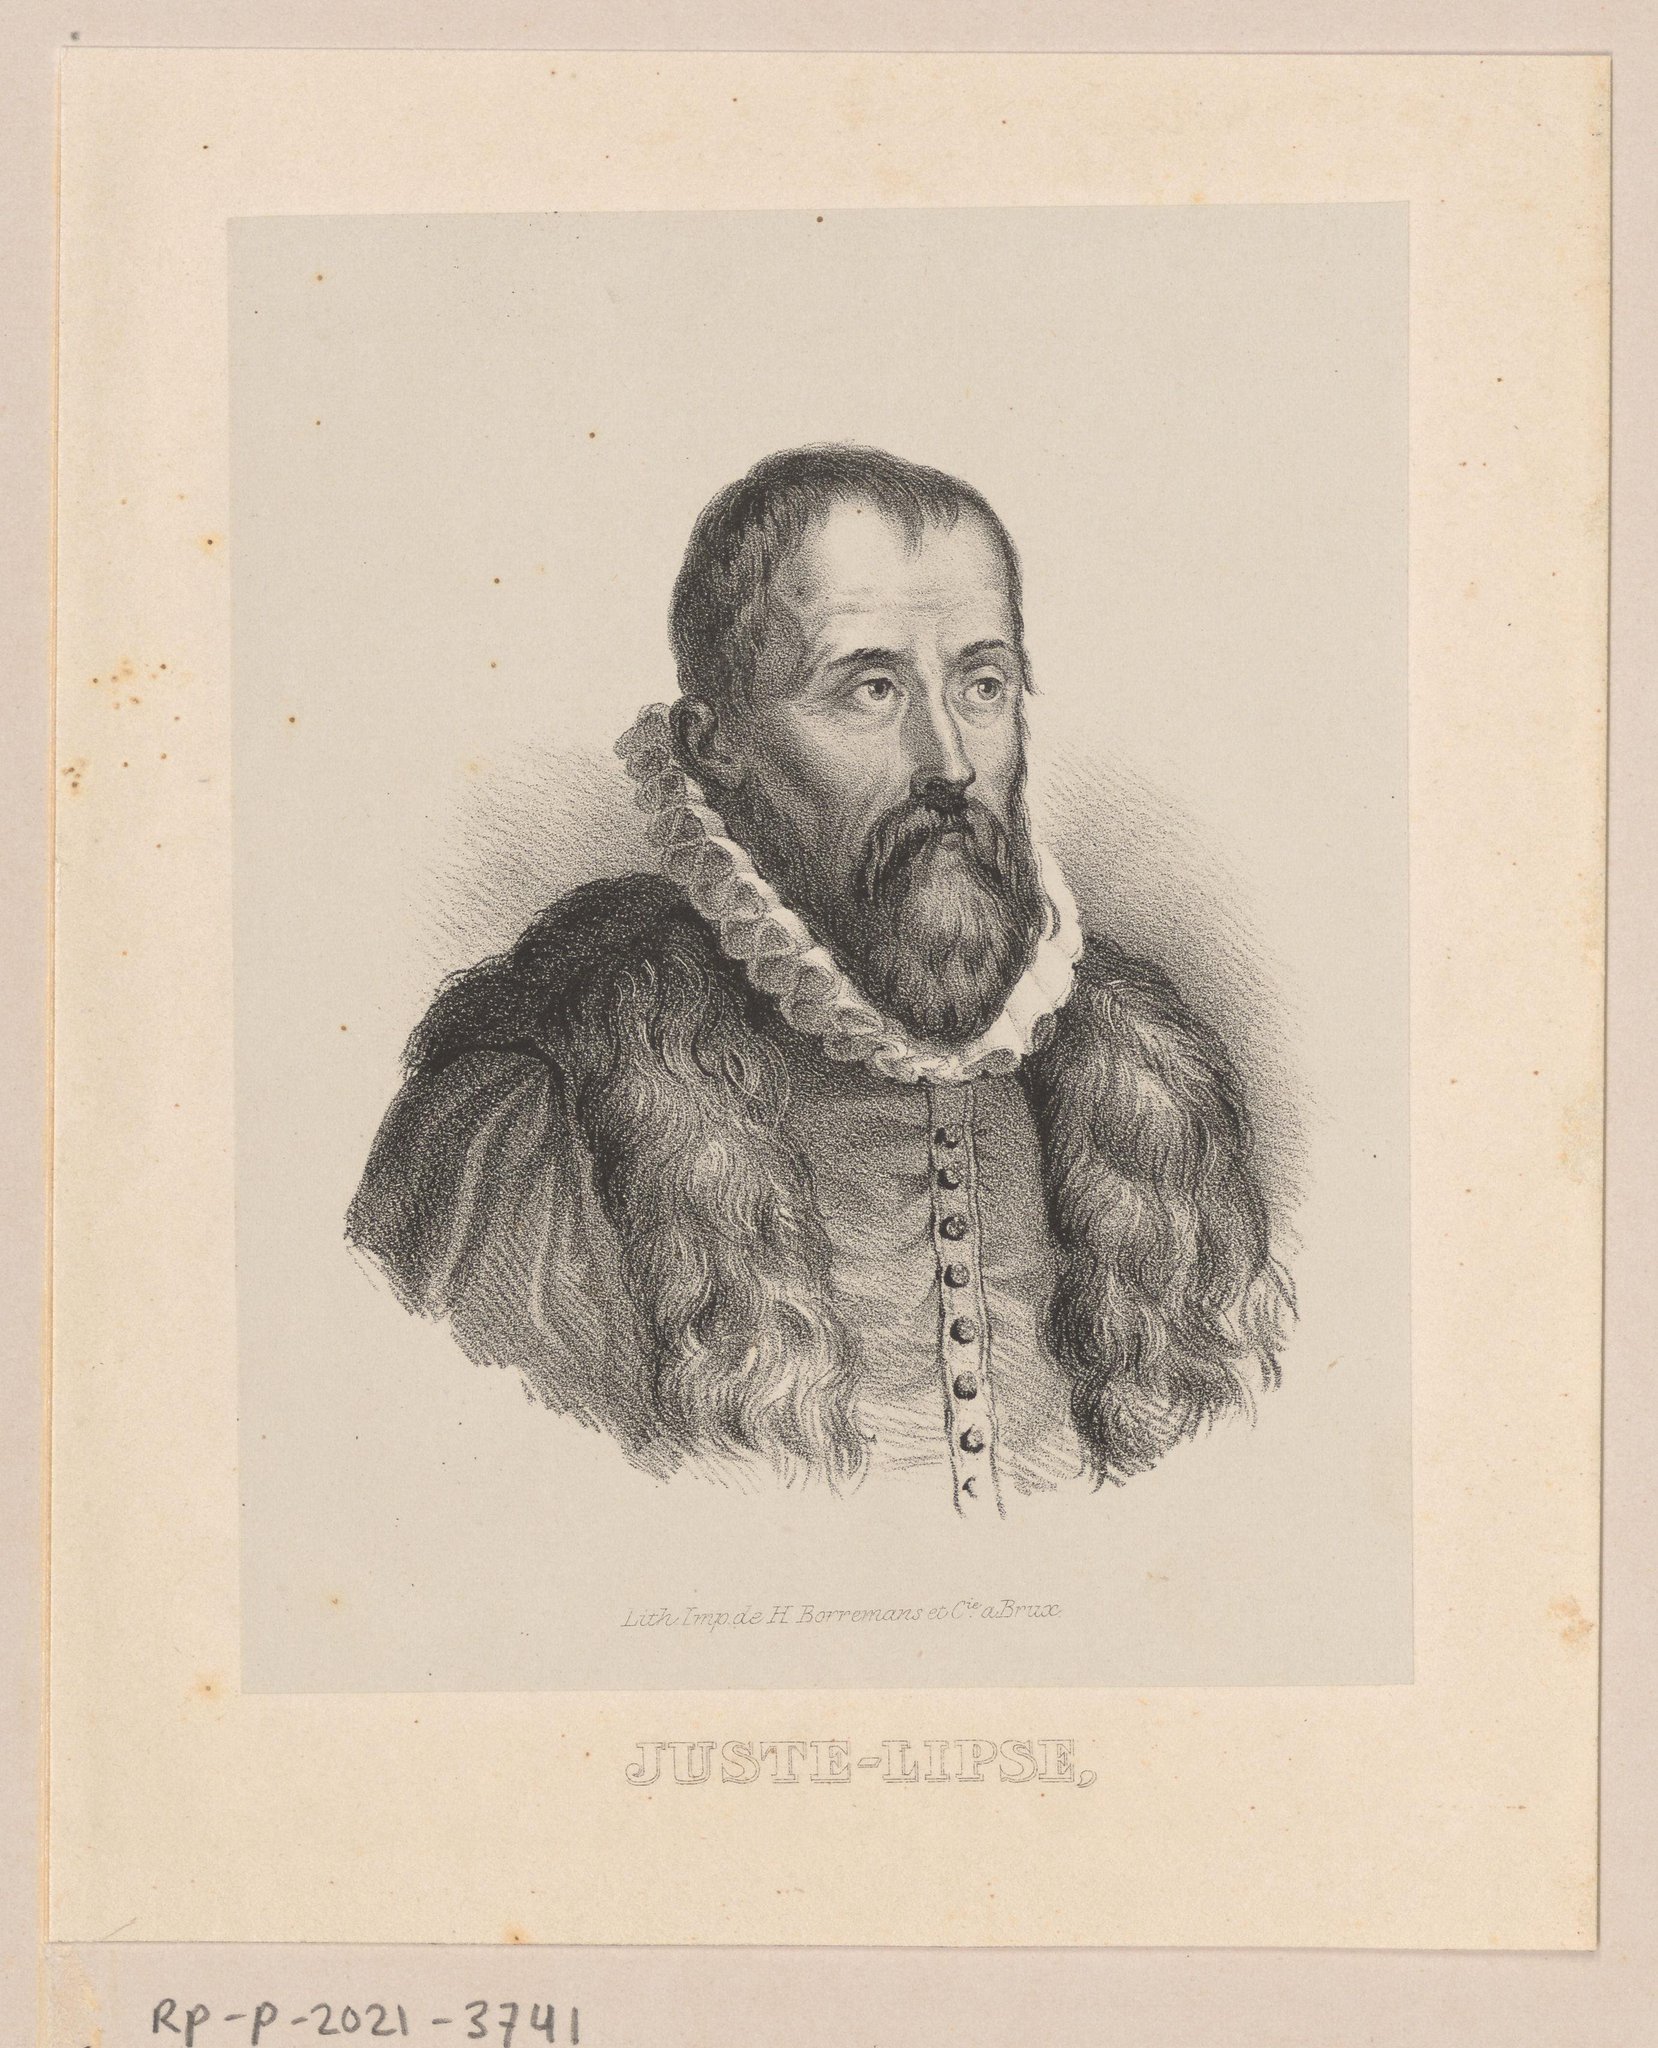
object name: print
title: Portret van Justus Lipsius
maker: Anonymous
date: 1800-1899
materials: paper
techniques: lithograph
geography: brussels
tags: louvain, justus lipsius, history and archaeology (+ portrait of scholar, scientist), historical persons